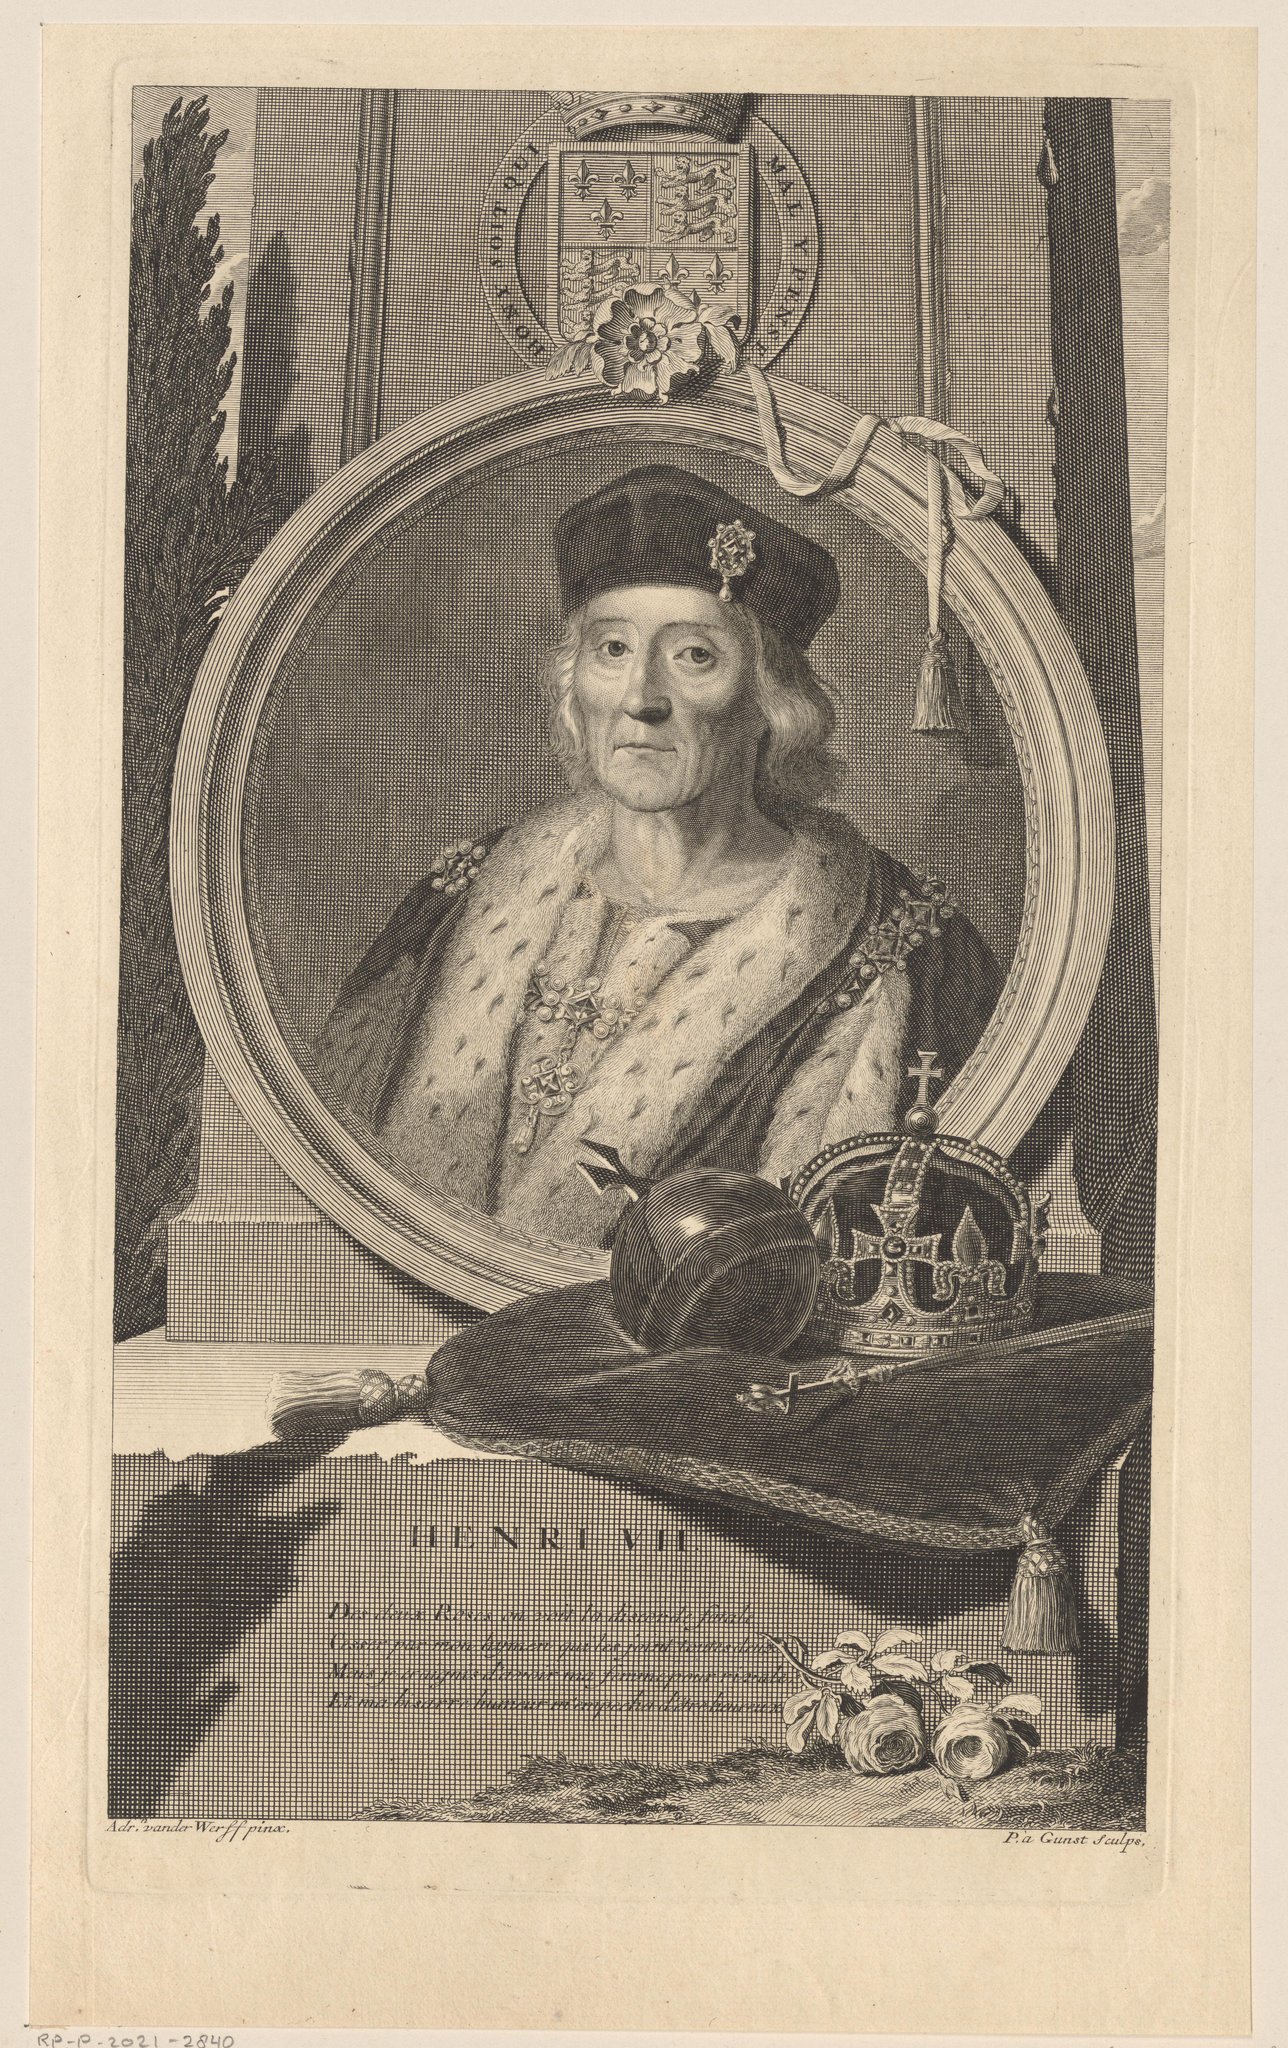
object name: print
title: Portret van Henry VII, koning van Engeland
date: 1668-1731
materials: paper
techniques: engraving, etching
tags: historical persons, king, armorial bearing, heraldry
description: Prent gebruikt in: Larrey, Isaac de. Histoire d'Angleterre, d'Ecosse, et d'Irlande. Rotterdam: Reinier Leers, 1697.